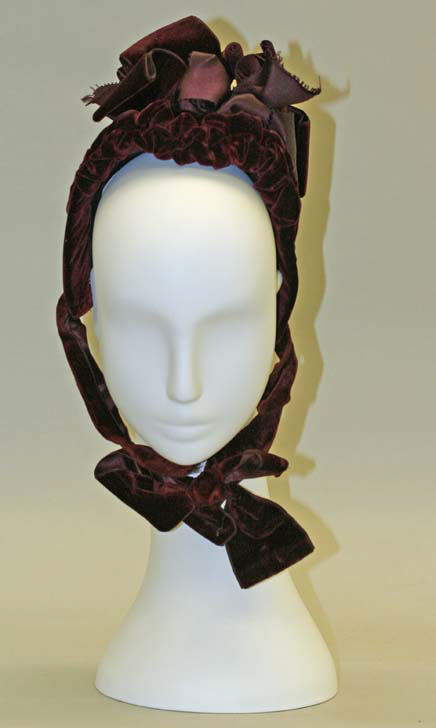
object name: bonnet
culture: american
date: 1885-1890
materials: silk